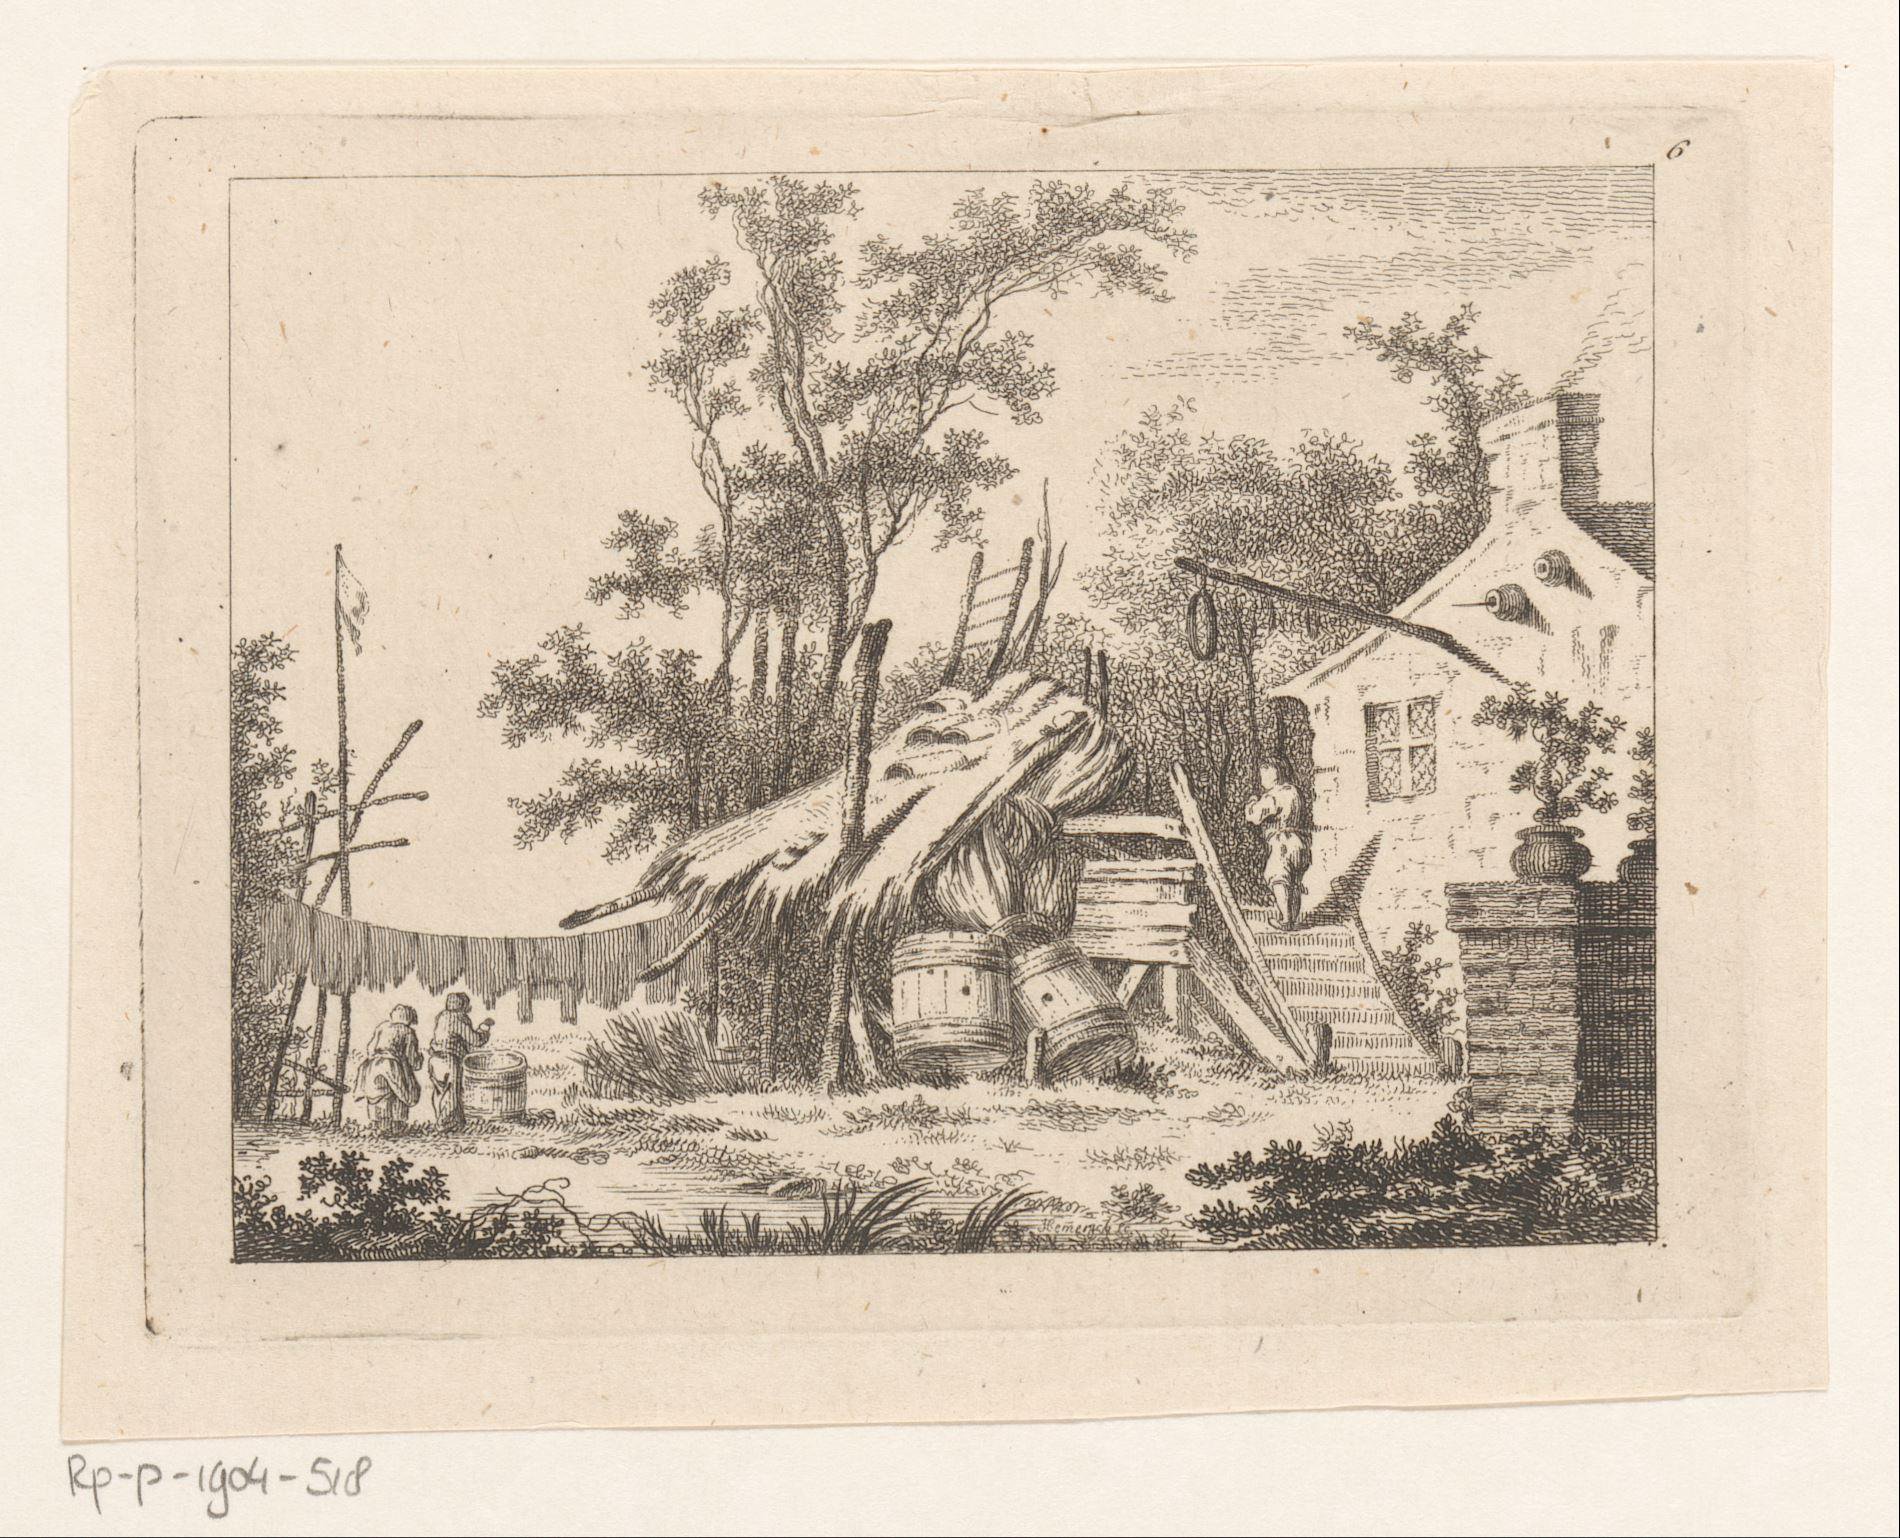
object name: print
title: Landschap met boerderij en mensen die de was ophangen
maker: cornelius heinrich hemerich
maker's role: print maker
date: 1740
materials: paper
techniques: etching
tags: farm or solitary house in landscape, hanging the wash to dry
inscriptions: collector's mark: Lugt 2228